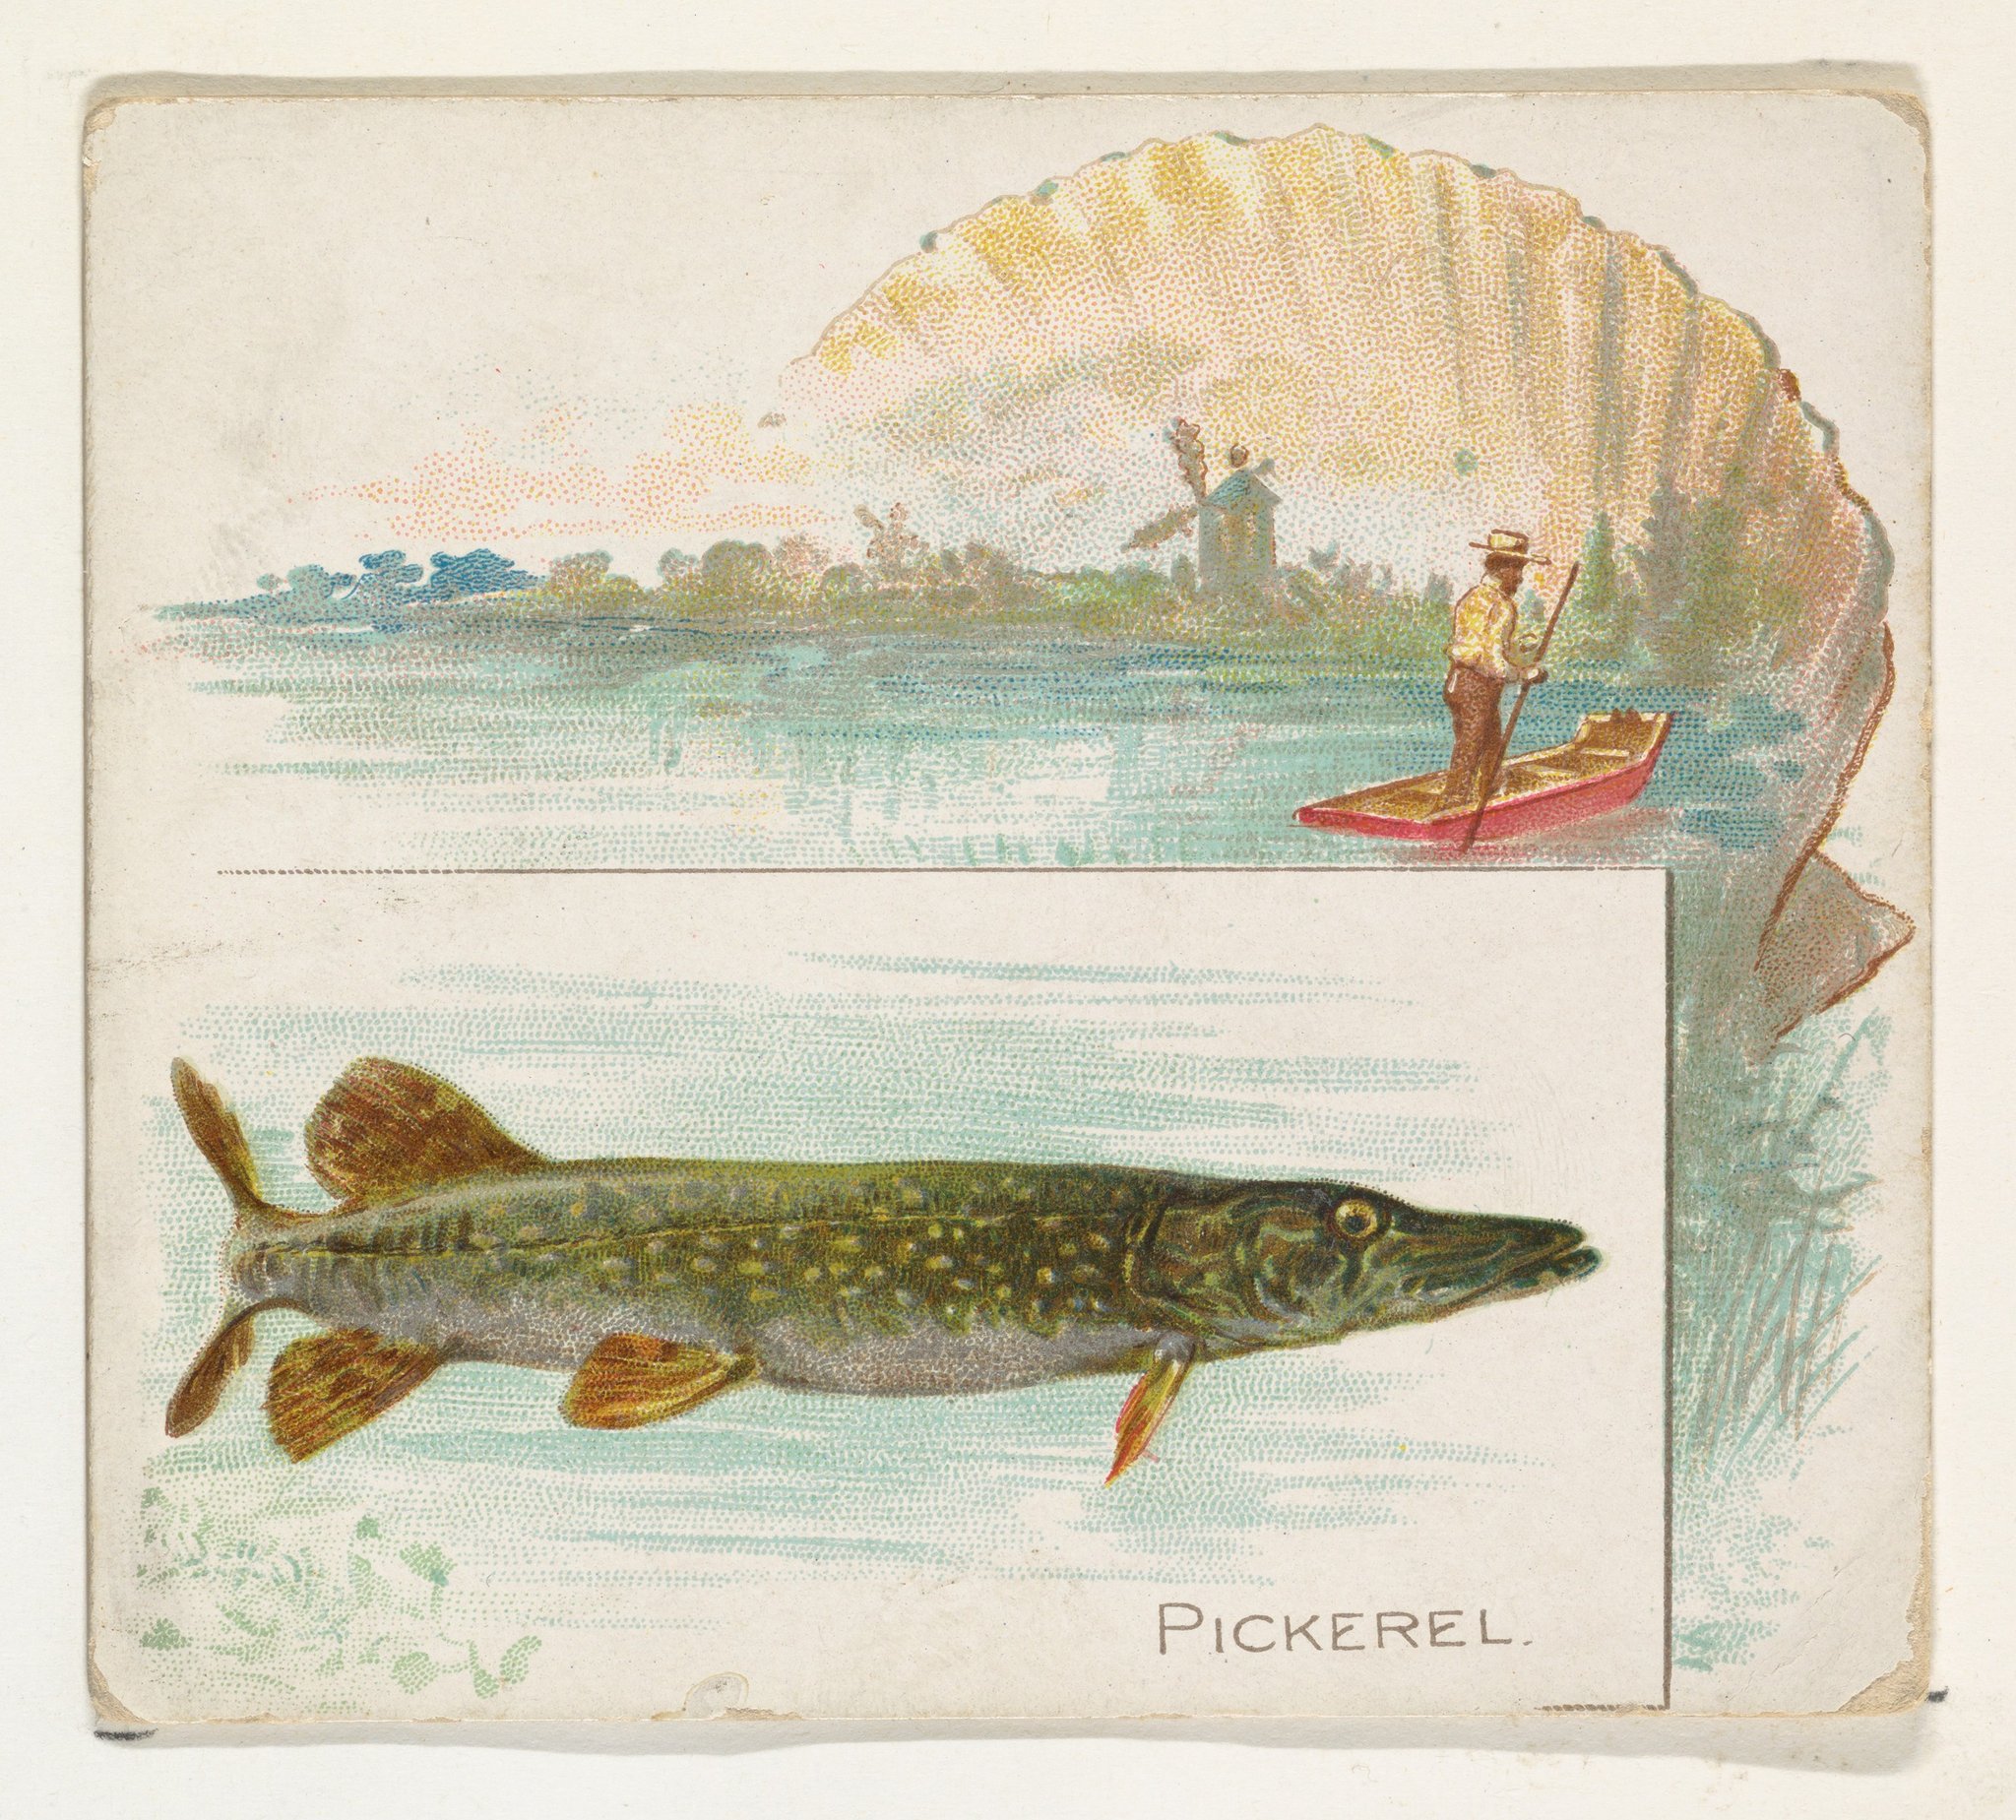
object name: print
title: Pickerel, from Fish from American Waters series (N39) for Allen & Ginter Cigarettes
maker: allen & ginter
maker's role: publisher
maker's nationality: american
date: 1889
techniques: color lithograph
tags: fish